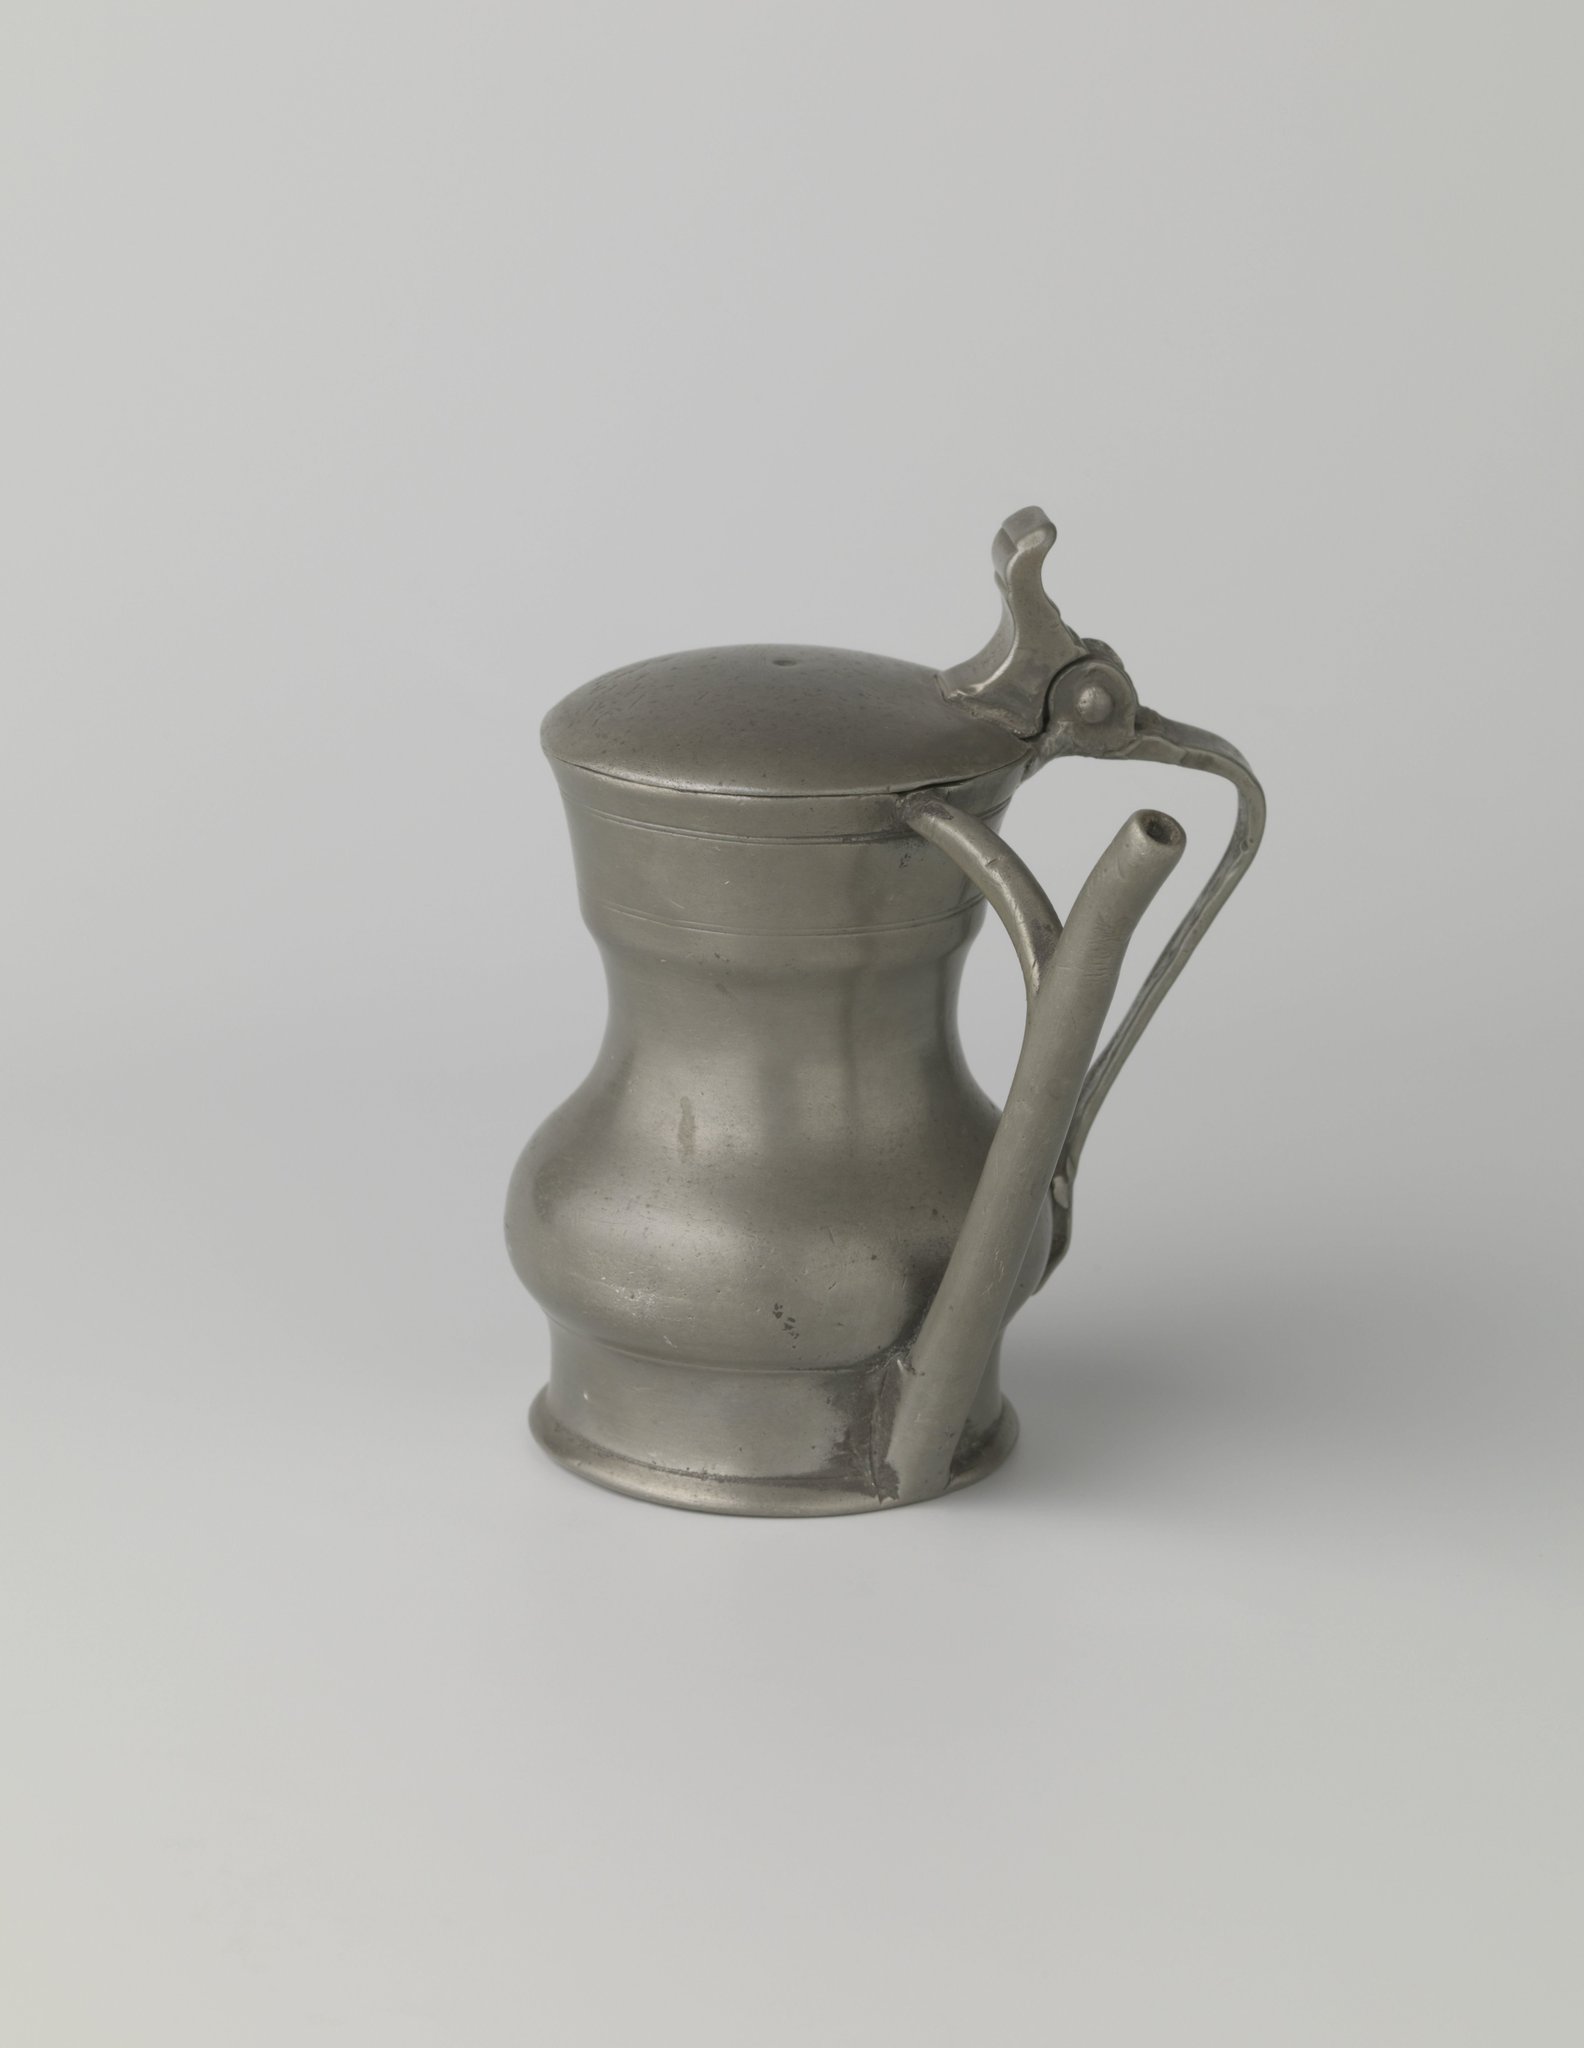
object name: tuitkan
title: Tuitkan van tin met deksel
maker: Anonymous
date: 1600-1650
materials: tin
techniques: casting, turning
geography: netherlands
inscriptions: quality mark, house mark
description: Schenkkan van tin, balustervormig met zijdelings geplaatst eenvoudig oor, waaraan het zwak gewelfde deksel met een scharnier is bevestigd. De tuit bestaat uit een buis, die uit de bodem ontspringt, schuin naar boven gaat en door middel van een verbindingsstuk aan de bovenrand aan de kan is bevestigd. Gemerkt in het deksel: gekroonde vaas.